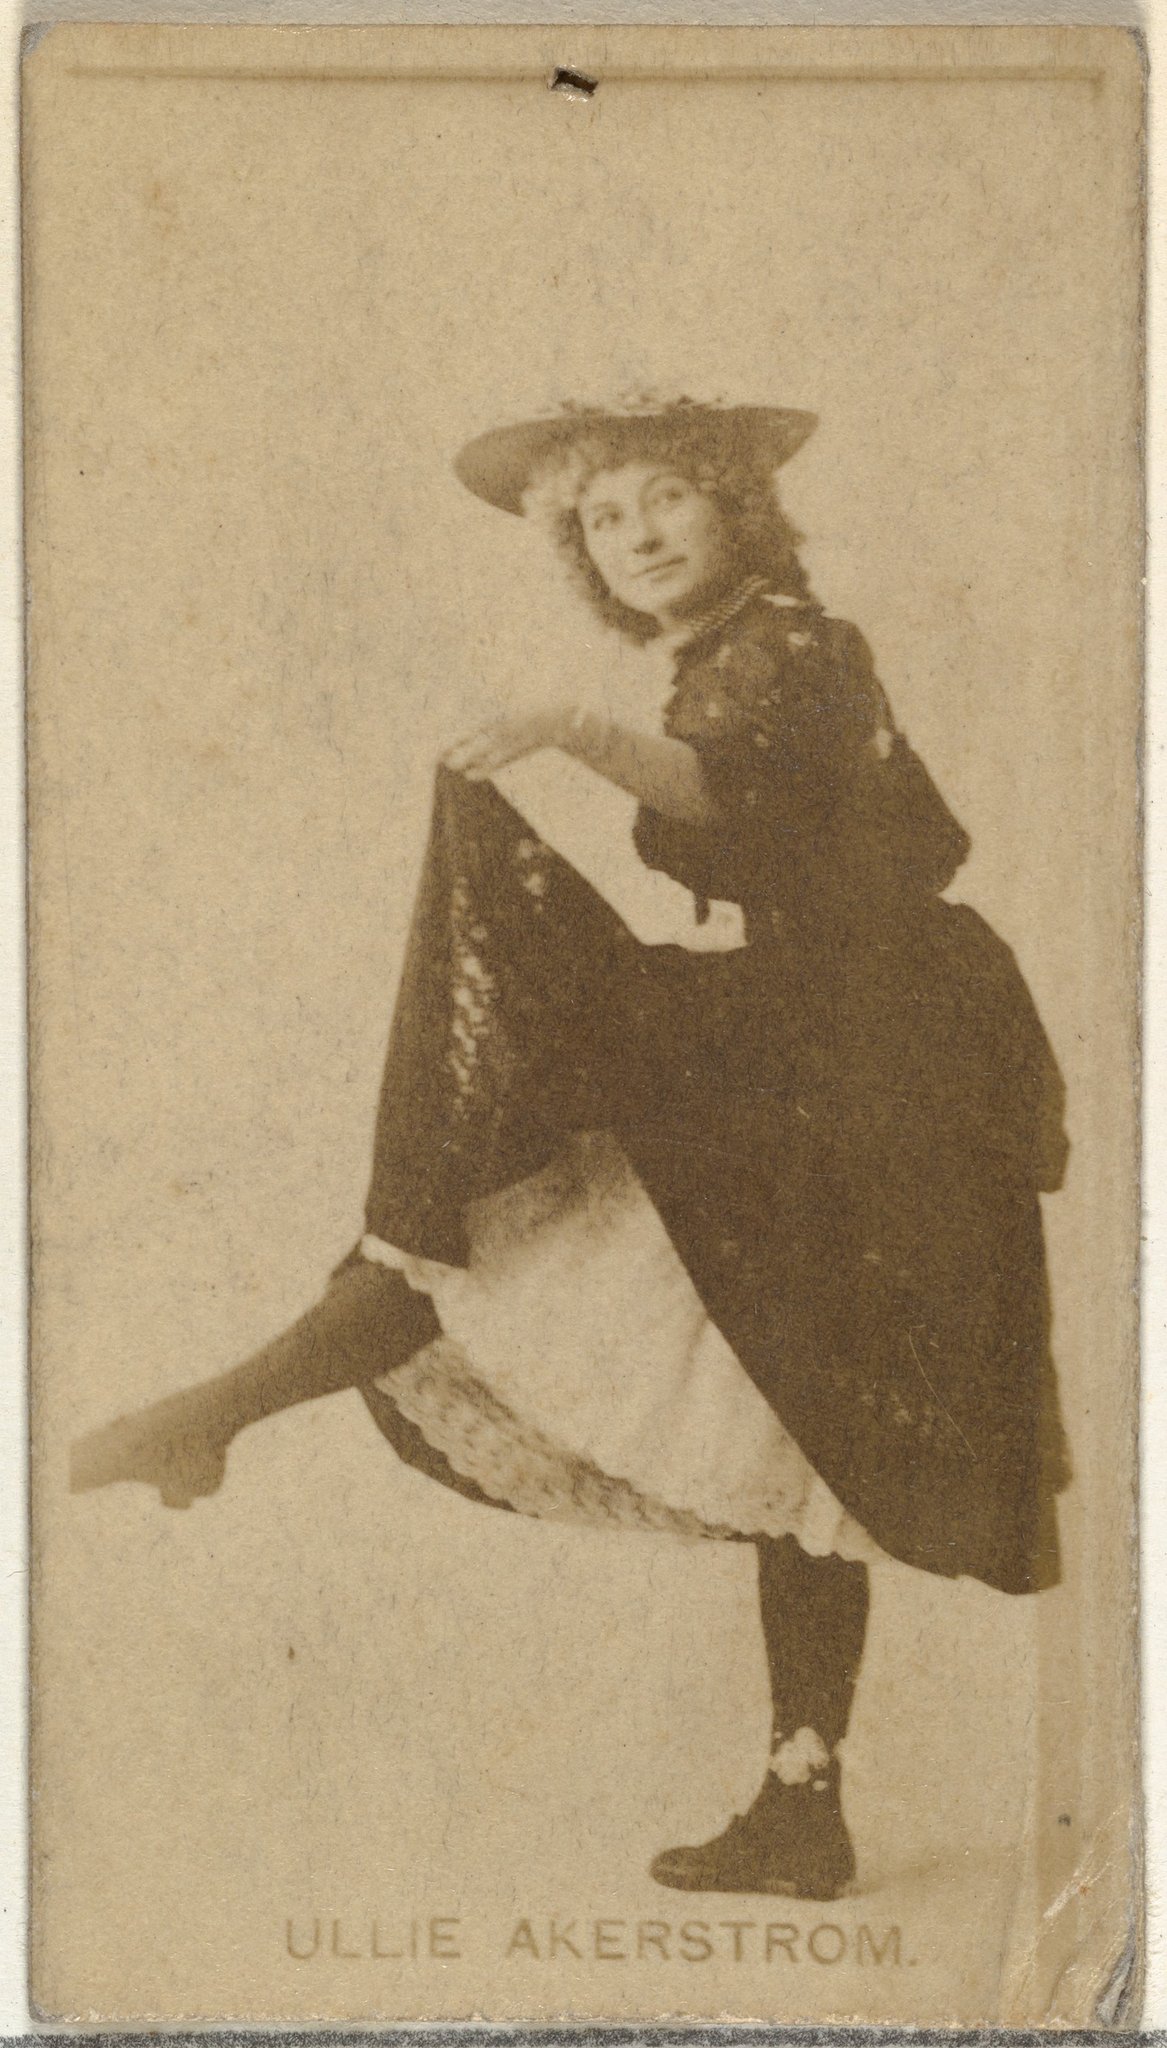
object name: photograph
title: Ullie Akerstrom, from the Actors and Actresses series (N145-8) issued by Duke Sons & Co. to promote Duke Cigarettes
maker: w. duke, sons & co.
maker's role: publisher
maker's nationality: american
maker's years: 1870-1920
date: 1891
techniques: albumen silver print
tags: portraits,women,actresses